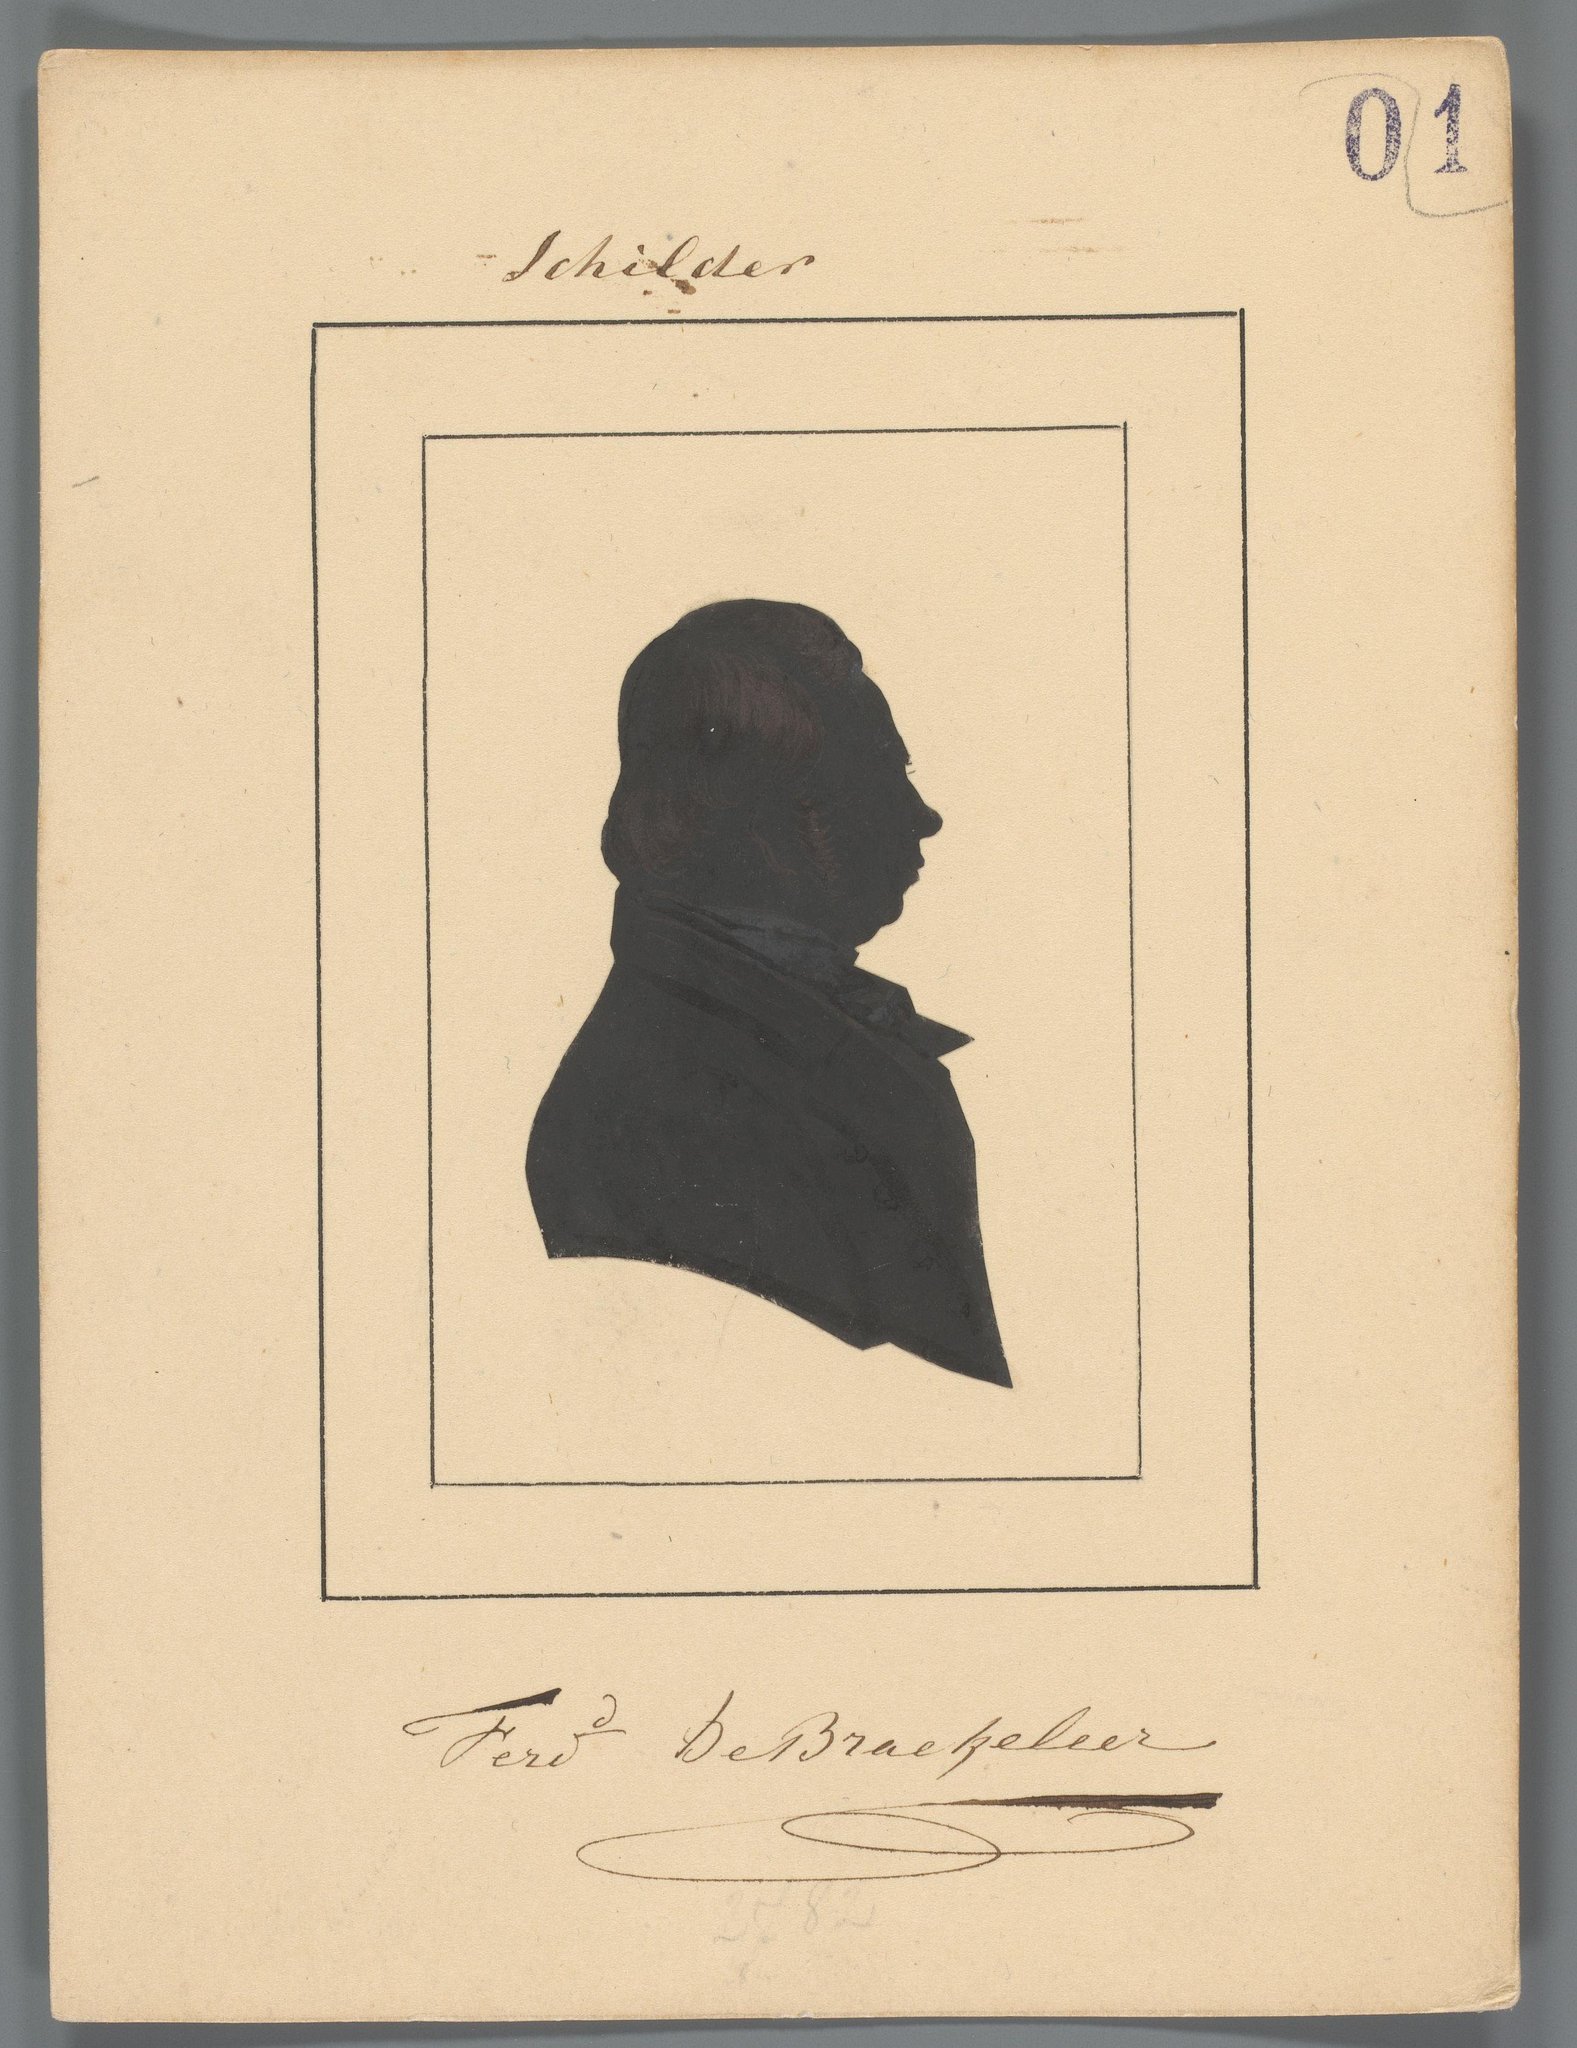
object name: silhouette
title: Silhouetportret van Ferdinand I De Braekeleer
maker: elisabeth alida haanen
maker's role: draughtsman, print maker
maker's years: 1809-1845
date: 1819-1845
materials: ink, paint, paper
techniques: brush, snipping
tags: antwerp, ferdinand de braekeleer (i), historical persons, portrait, self-portrait of painter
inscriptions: inscription: ‘Neg. D. 1756’, number: ‘01’, number: ‘13942’, inscription: ‘Ferdd De Braekeleer’, inscription: ‘Schilder’, collector's mark: ‘Ex-libris van Beresteyn’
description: Met onder het portret de handtekening van de geportretteerde.